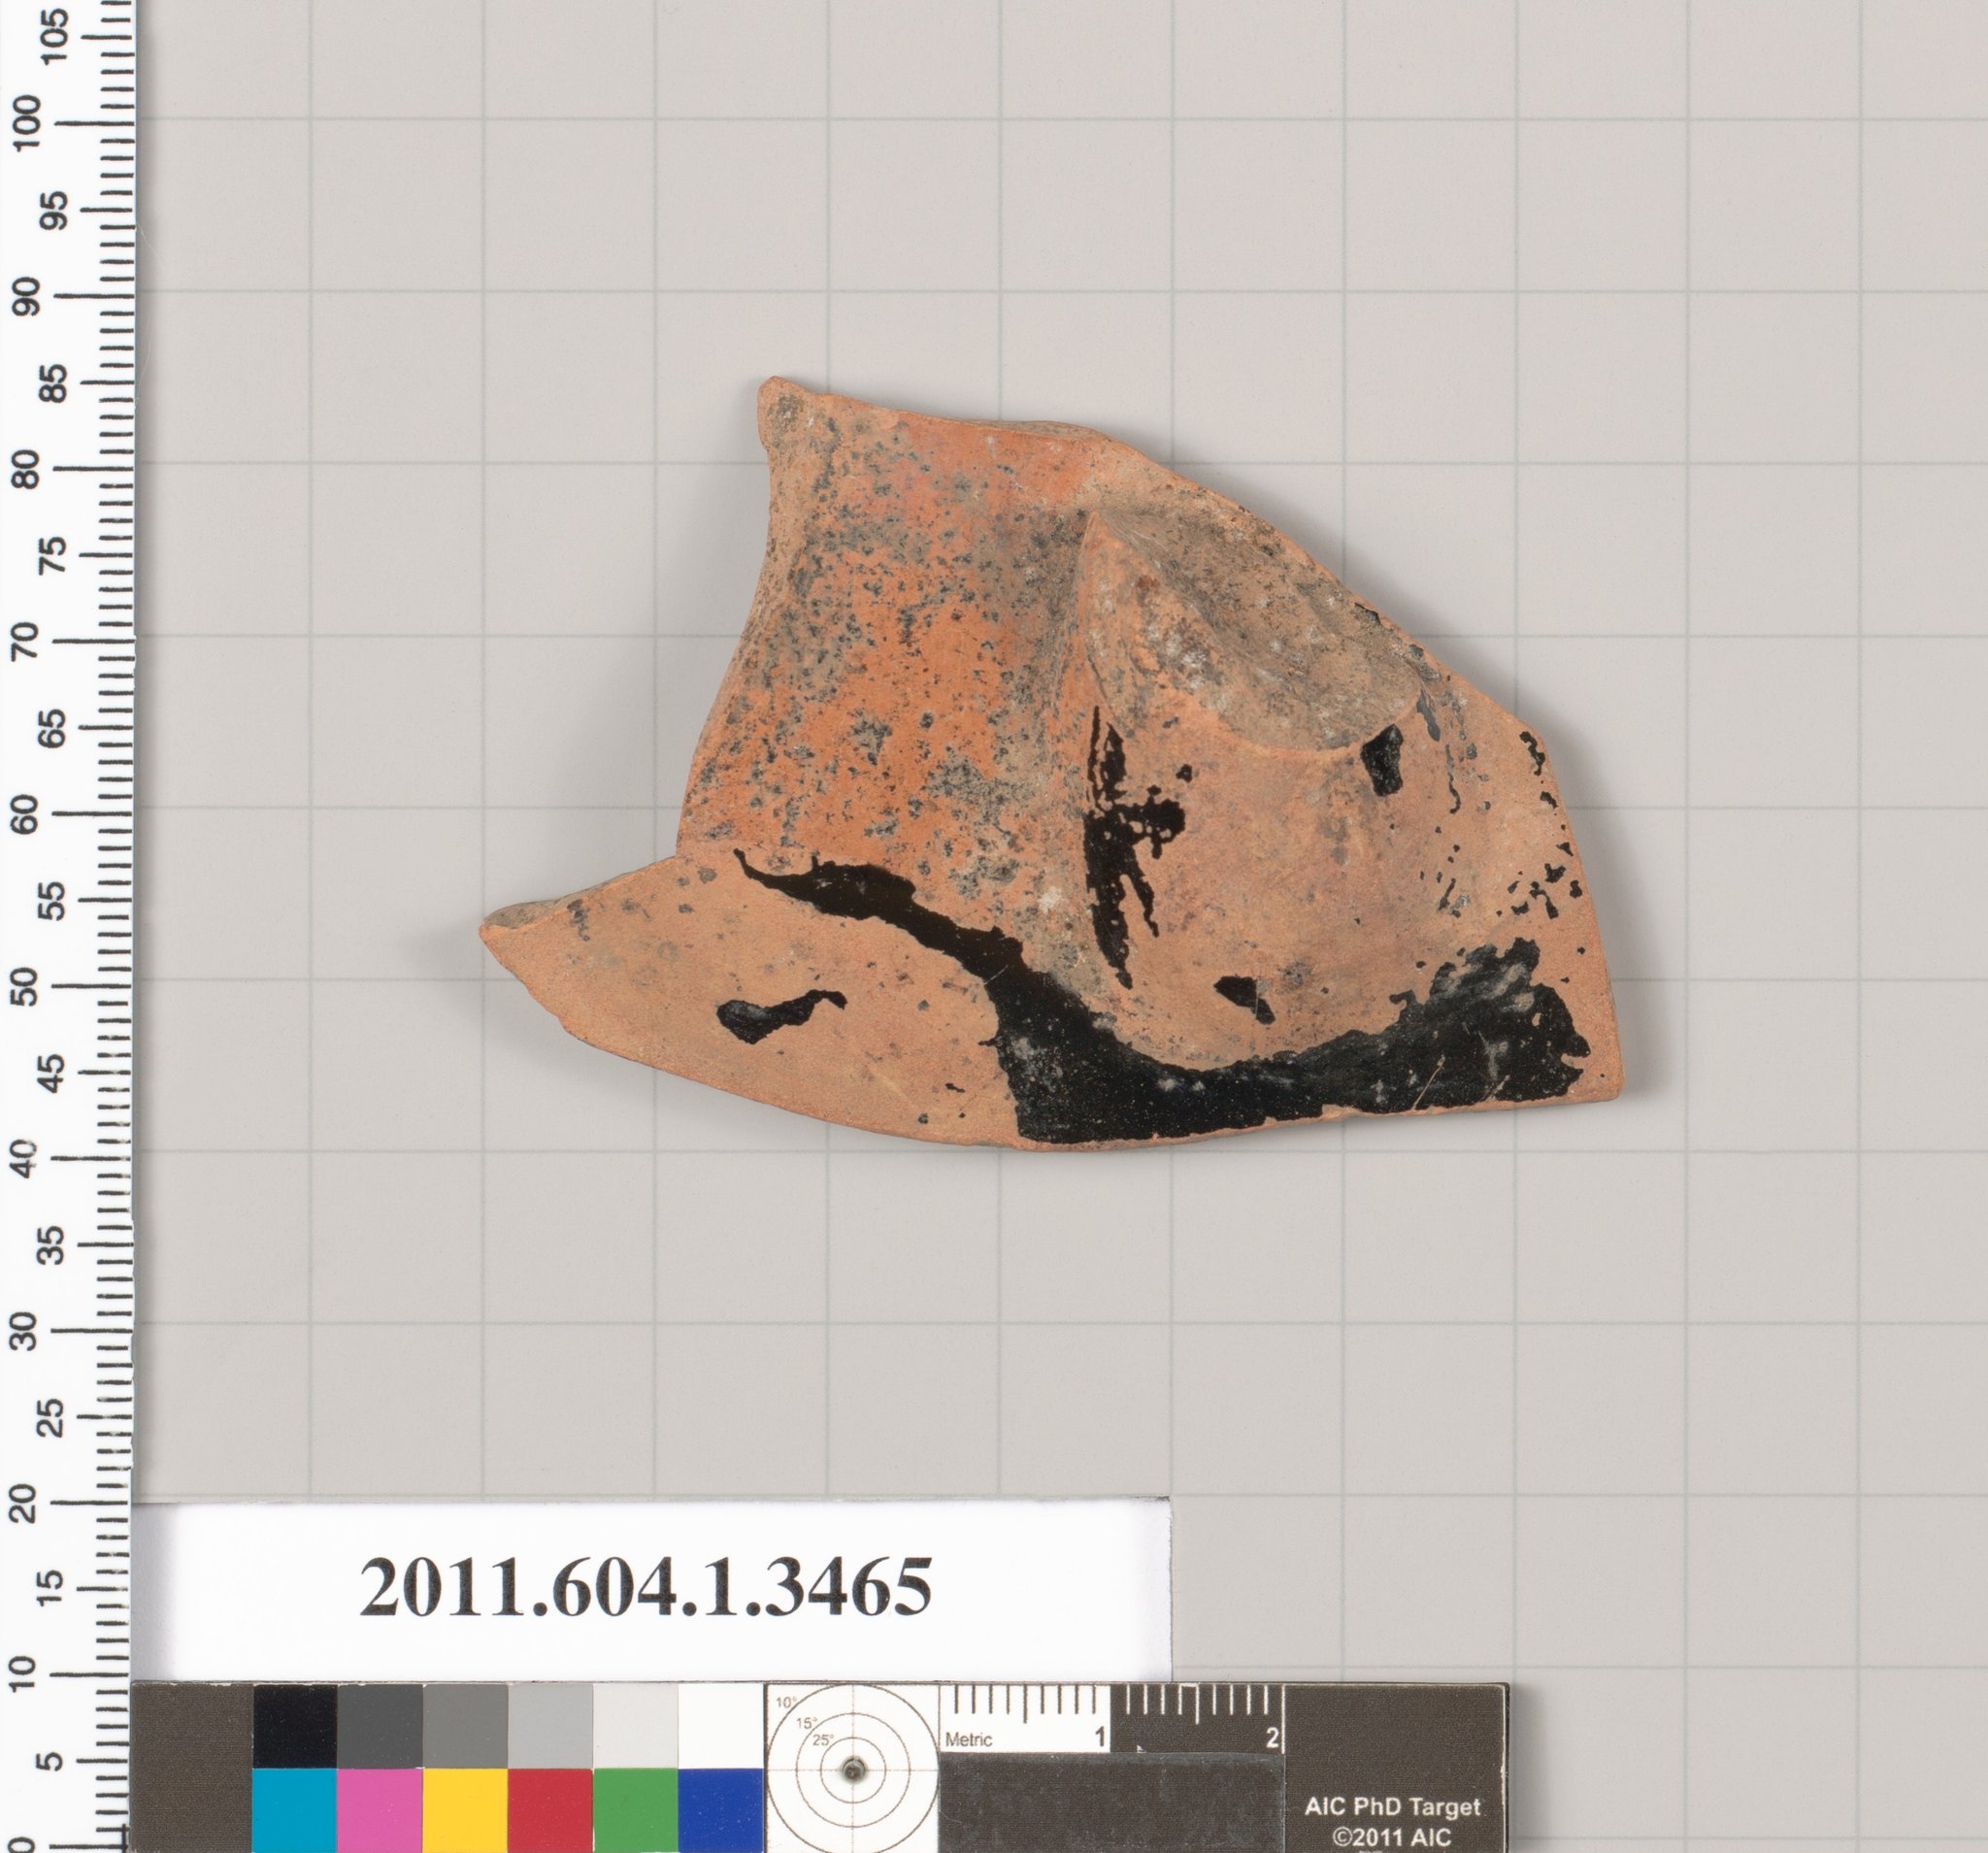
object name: kylix fragment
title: Terracotta fragment of a kylix (drinking cup)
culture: greek, attic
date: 600-401 BCE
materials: terracotta